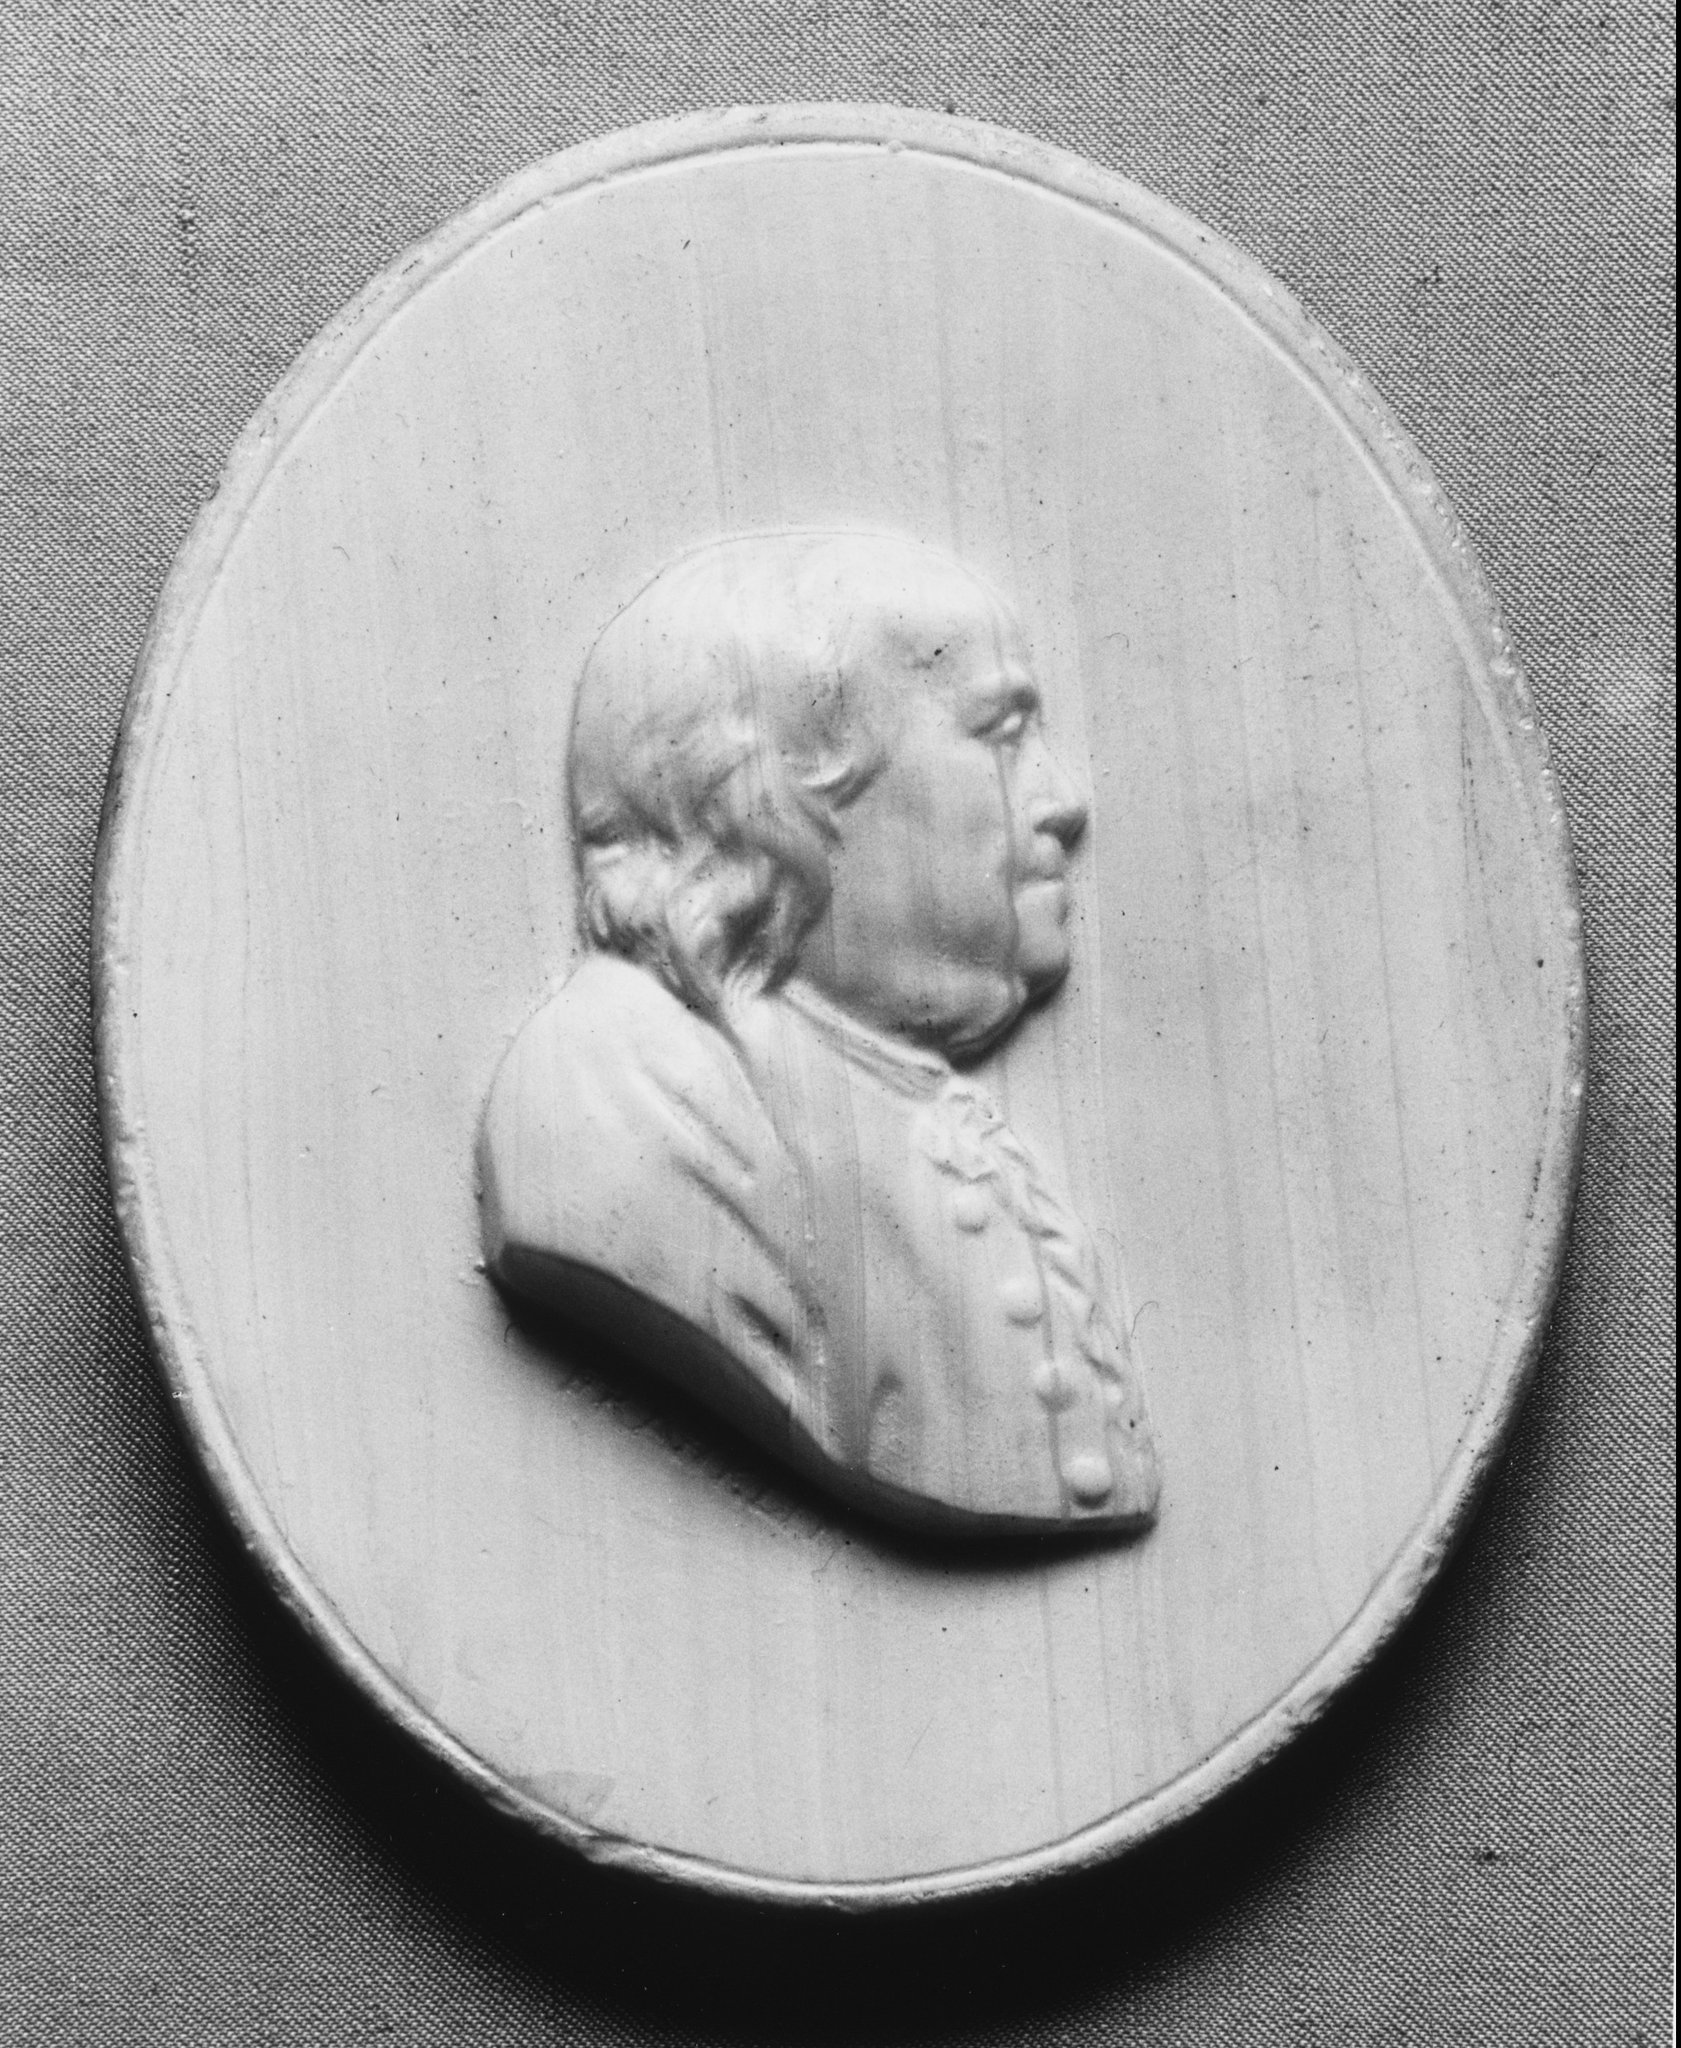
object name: plaque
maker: james tassie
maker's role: artist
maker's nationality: british, scottish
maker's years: 1735-1799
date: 1776-1883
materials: glass, paste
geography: england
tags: men,profiles